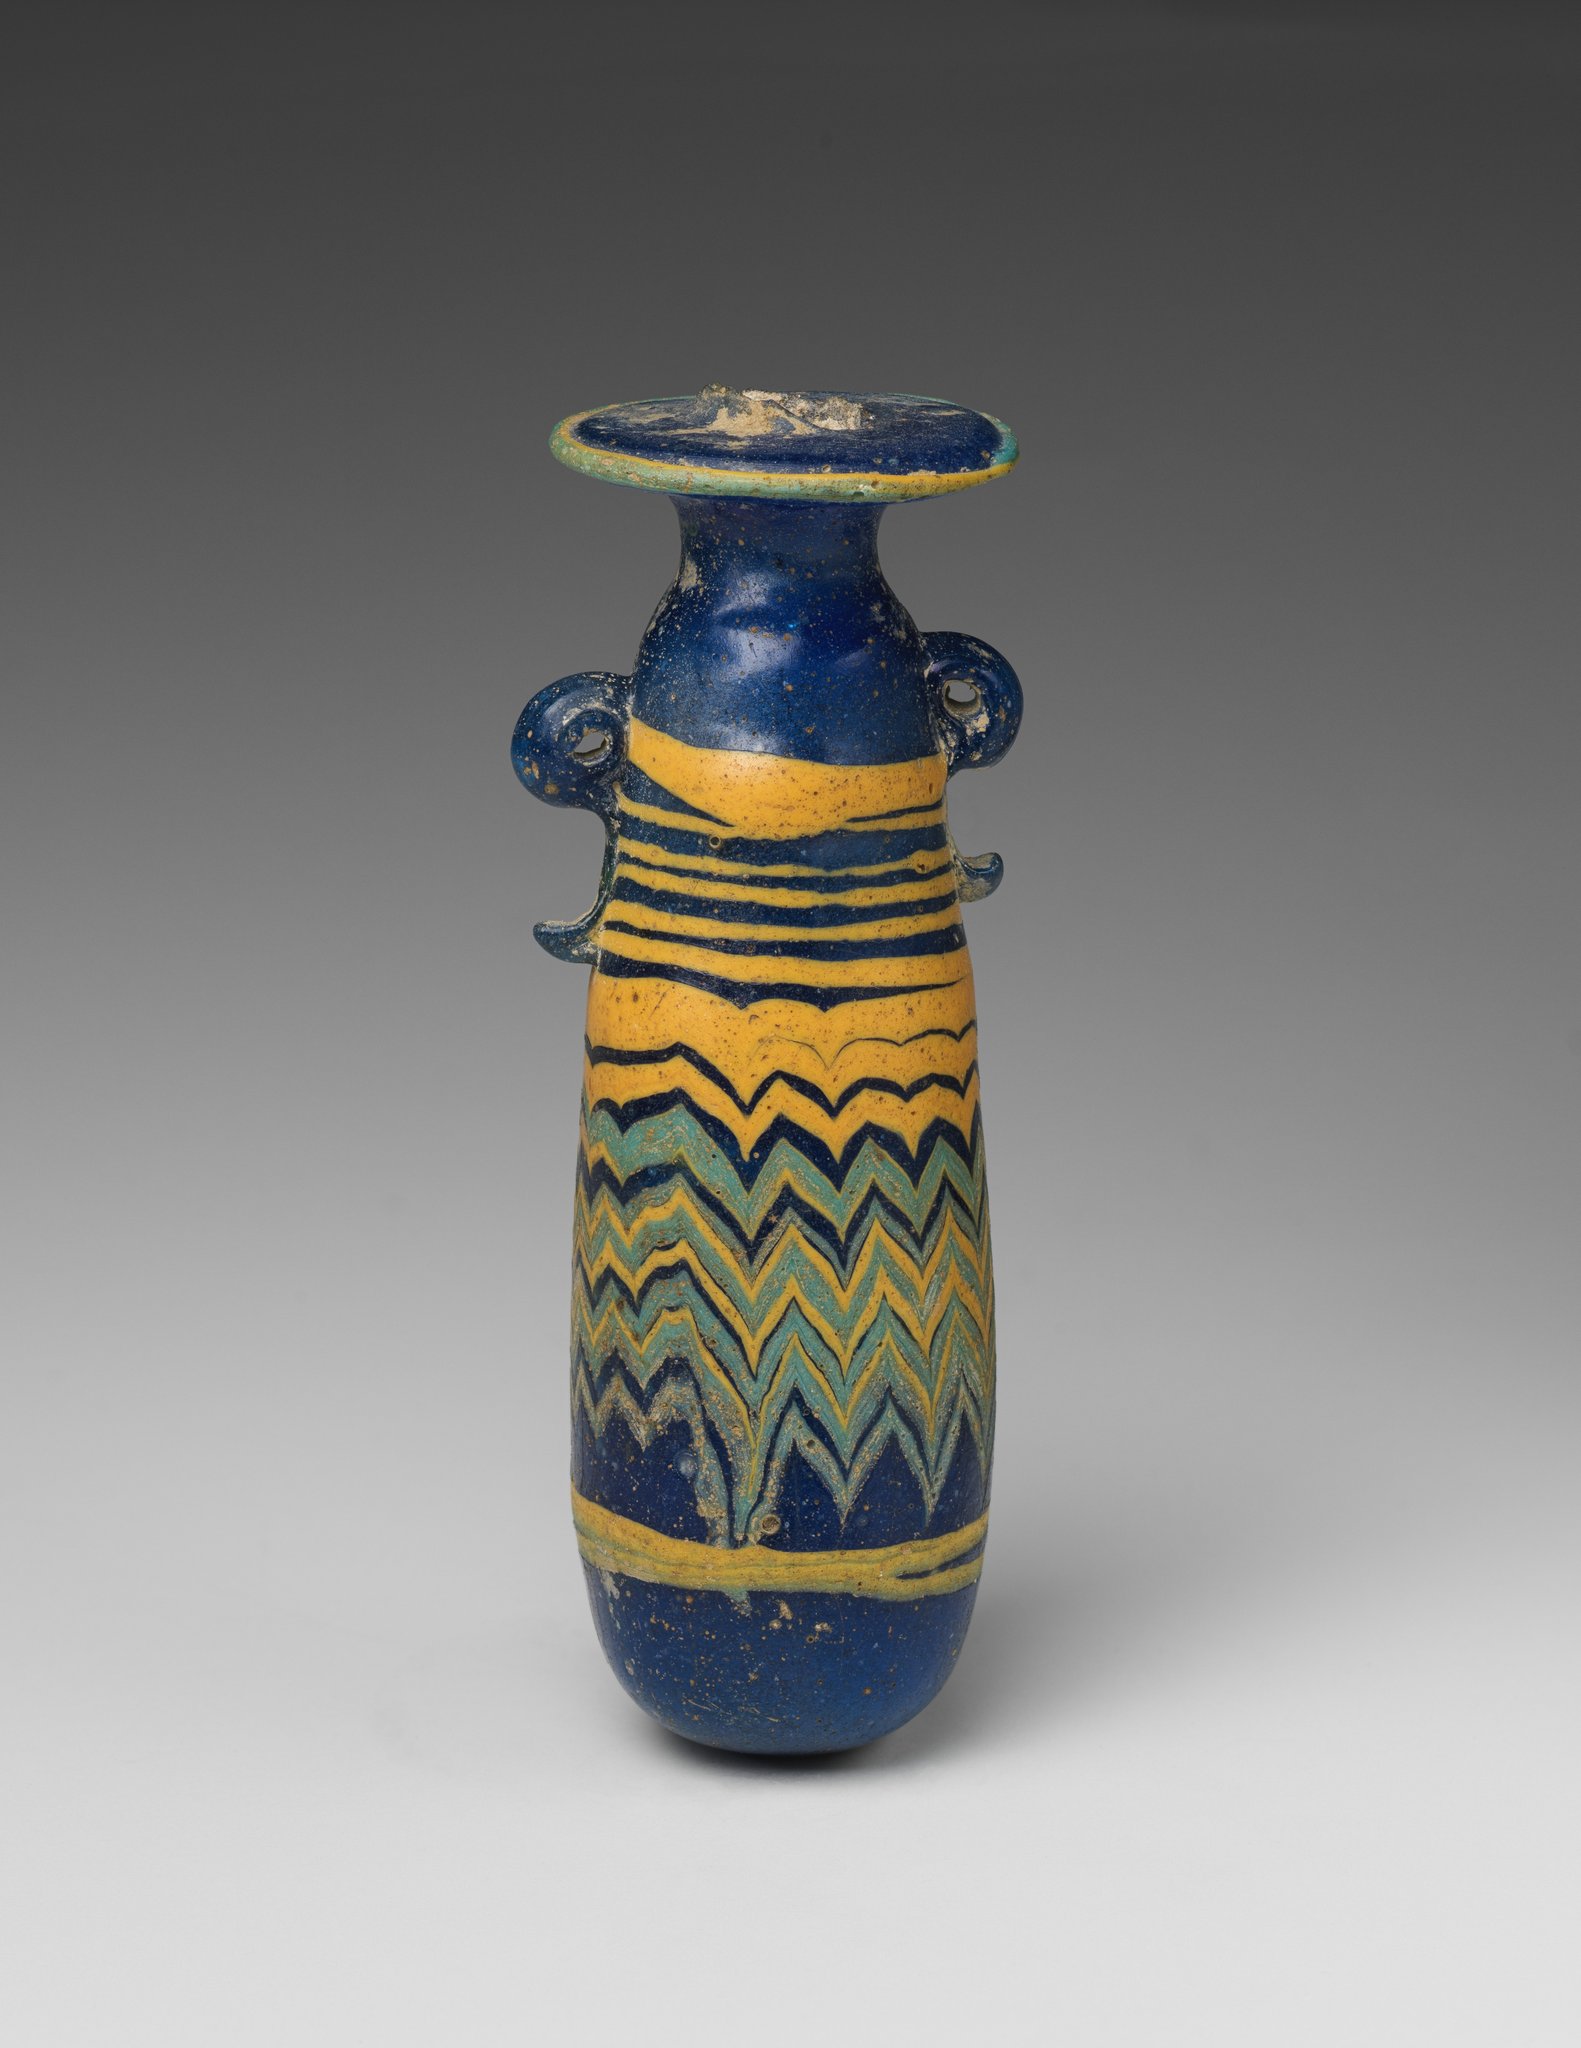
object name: vase, alabastron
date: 664-332 BCE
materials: glass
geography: egypt